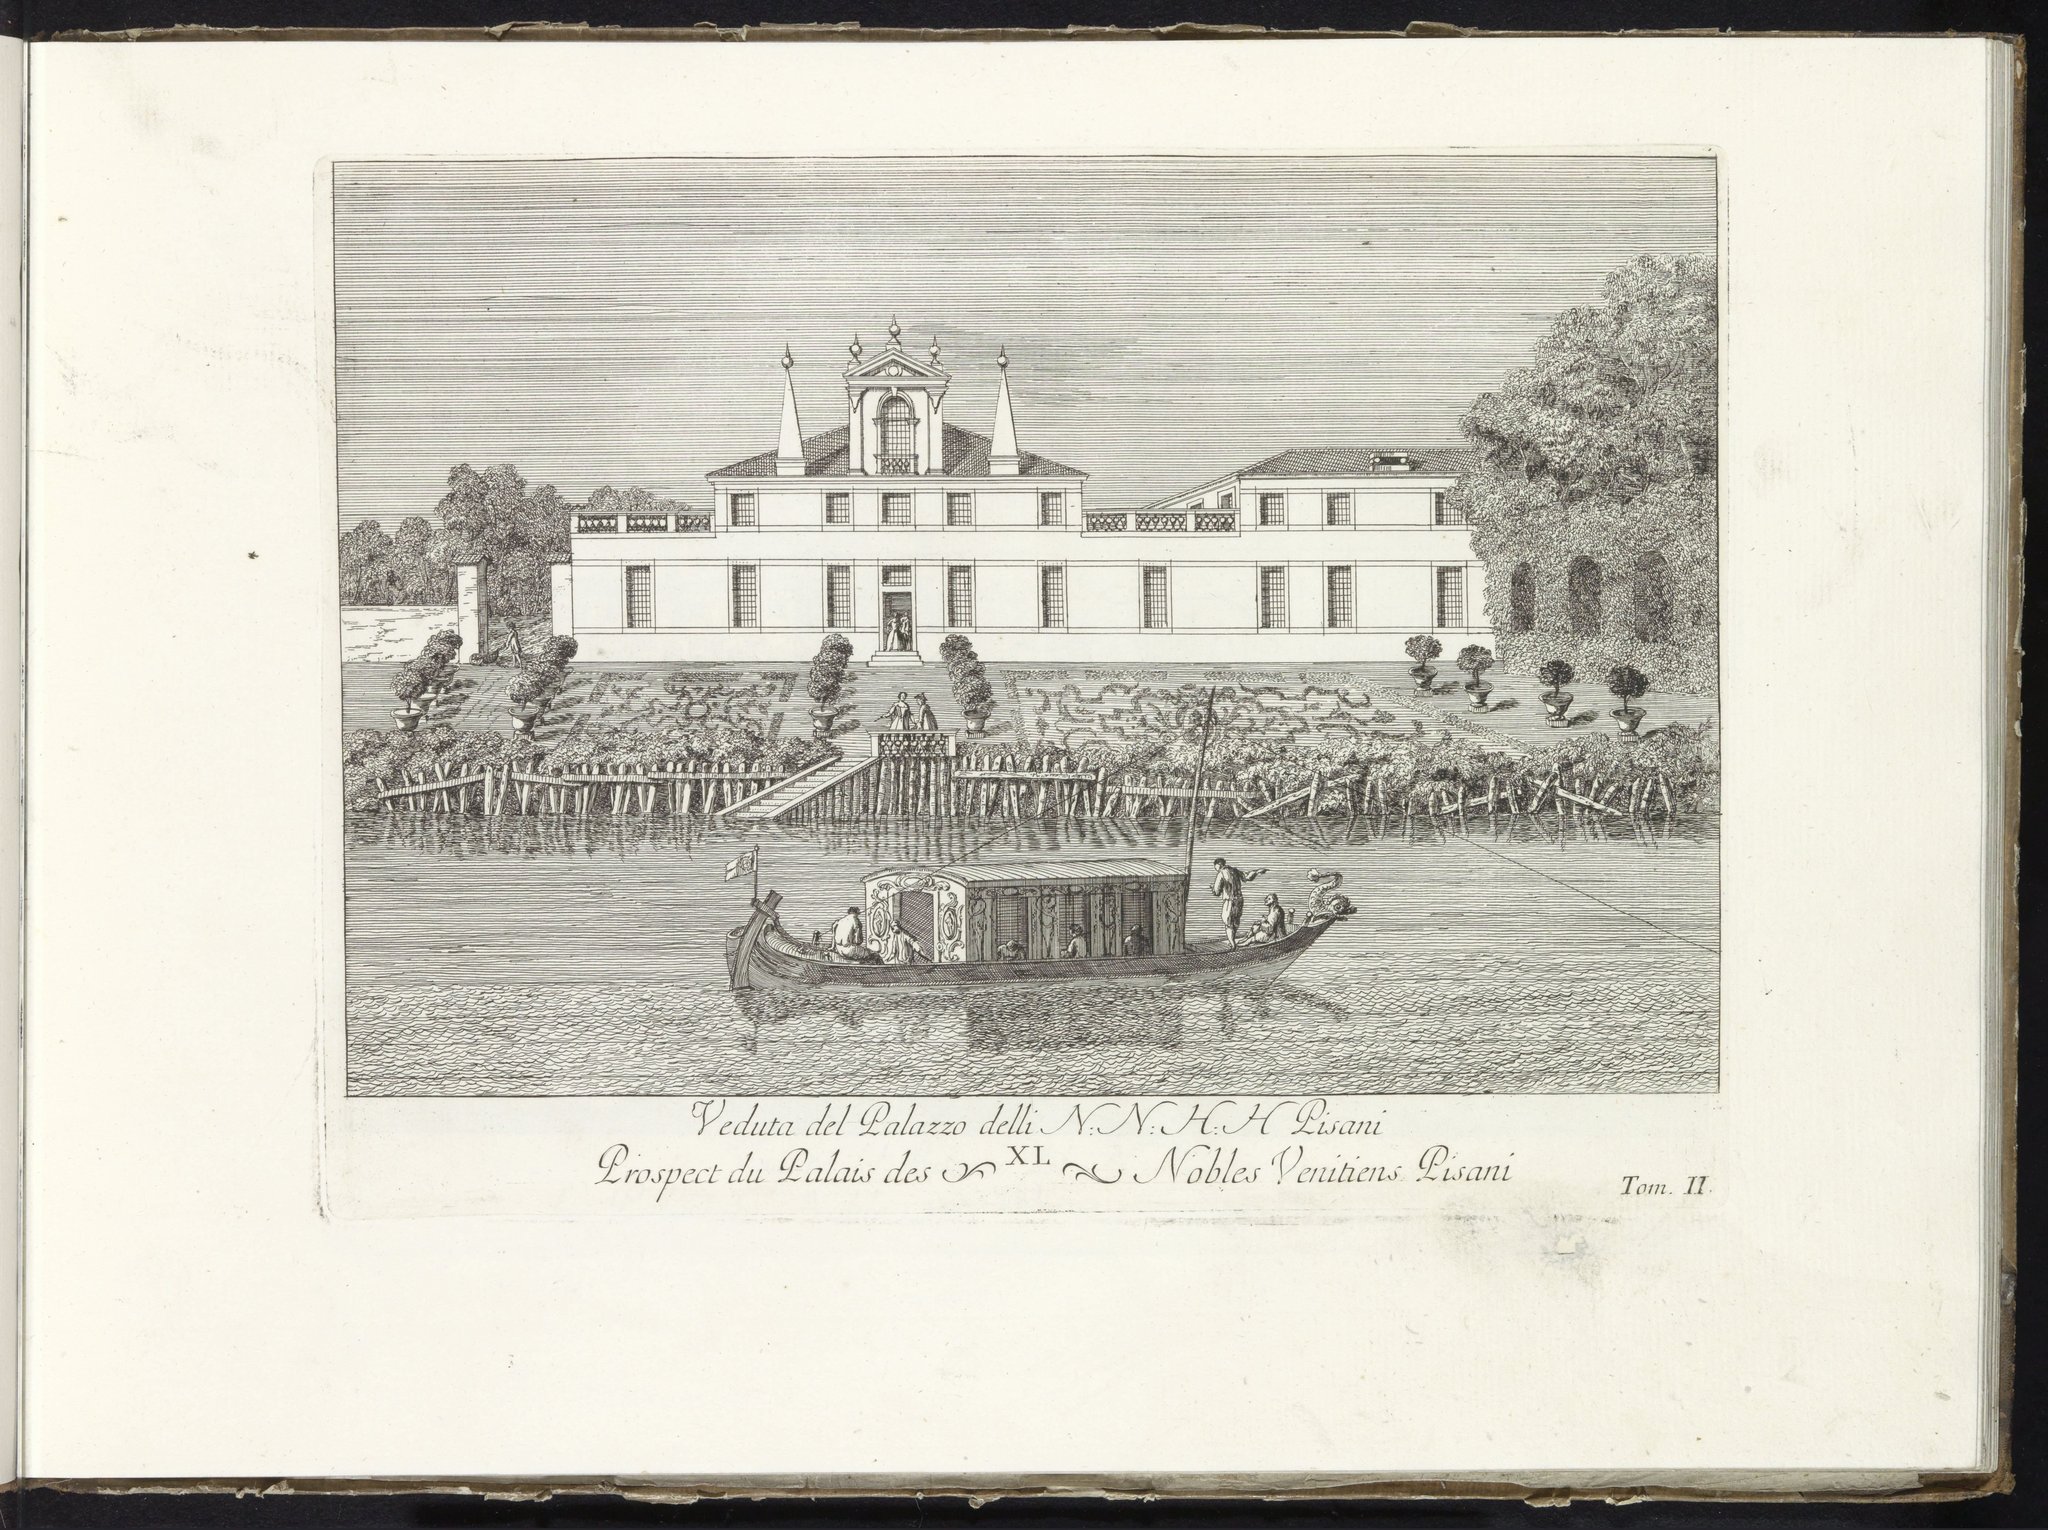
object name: print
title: Le delicie della Brenta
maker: giovanni francesco costa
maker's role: draughtsman, painter, print maker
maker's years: -1773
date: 1750-1760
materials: paper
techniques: etching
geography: venice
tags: river, garden, hôtel, i.e. small palace in city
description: Gezicht op Palazzo delli N: N: H: H: Pisan en bijbehorende tuin aan de rivier de Brenta. Op het water vaart een trekschuit. Genummerd midden onder: XL en rechtsonder: Tom: II. Deze prent maakt deel uit van een album.